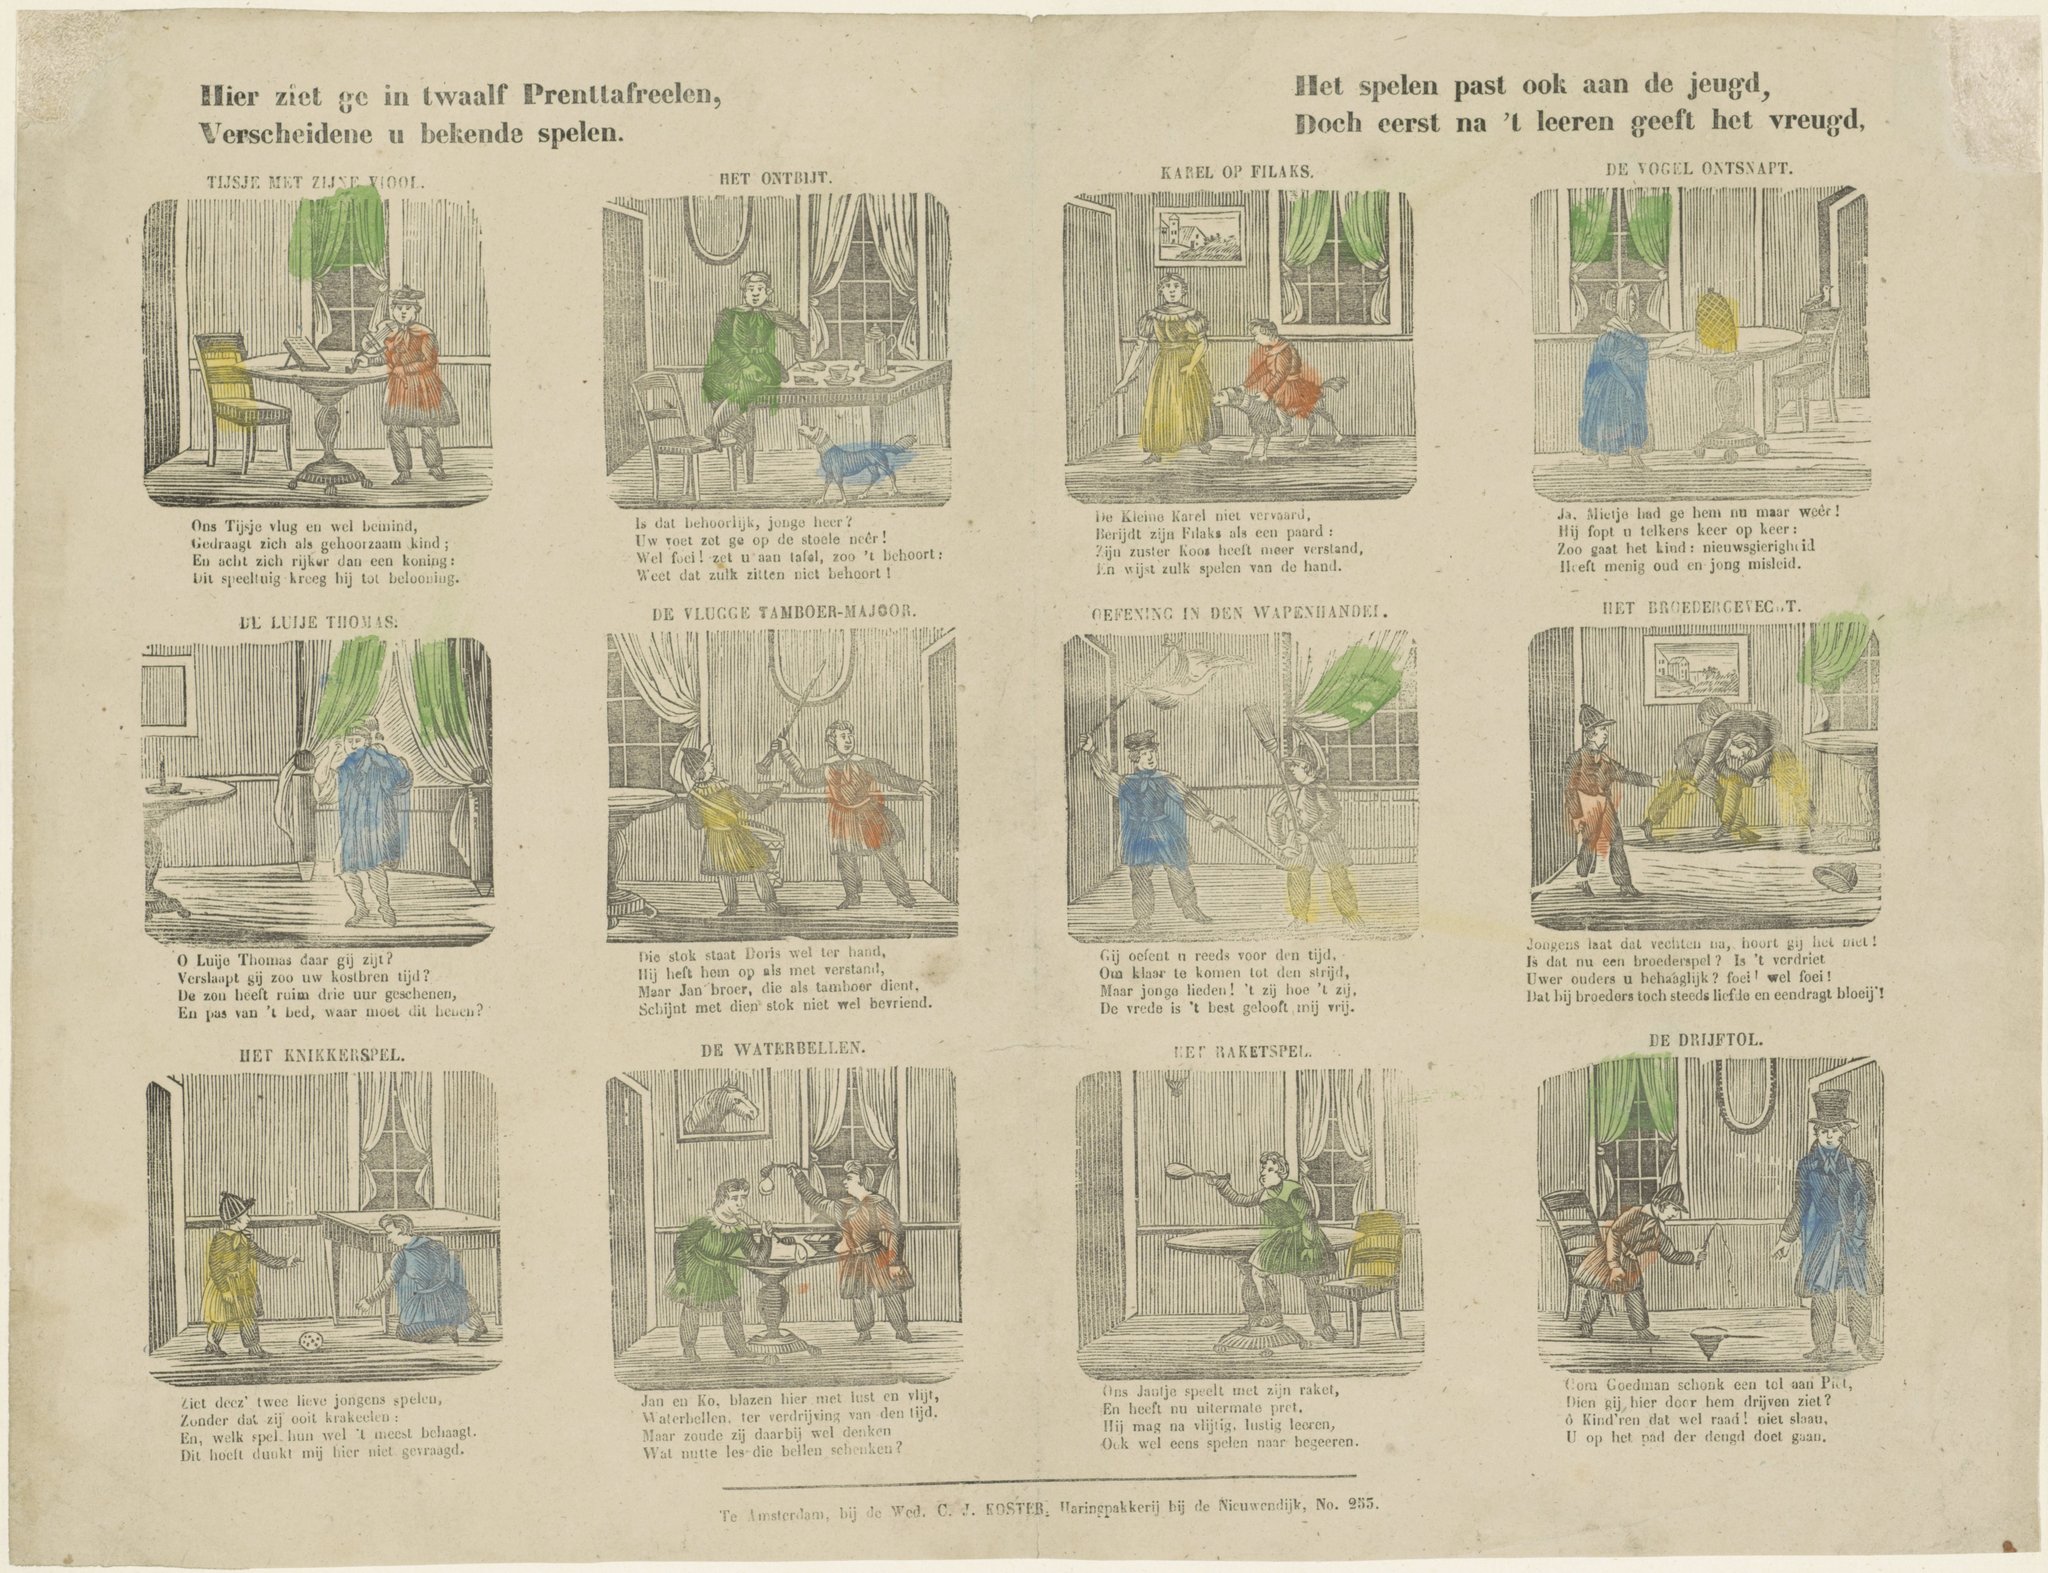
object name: print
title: Hier ziet ge in twaalf prenttafreelen, / Verscheidene u bekende spelen. / Het spelen past ook aan de jeugd, / Doch eerst na 't leeren geeft het vreugd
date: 1825-1847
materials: paper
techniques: colour, letterpress printing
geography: netherlands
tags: children's games and plays, child, child playing with animals, games using special objects (marbles, top, hoop, etc.)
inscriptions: collector's mark: Lugt 2760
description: Blad met 12 voorstellingen van kinderspelen en bezigheden, waaronder knikkeren, bellen blazen en tollen. Onder elke afbeelding een vierregelig vers en boven elke afbeelding een titel.